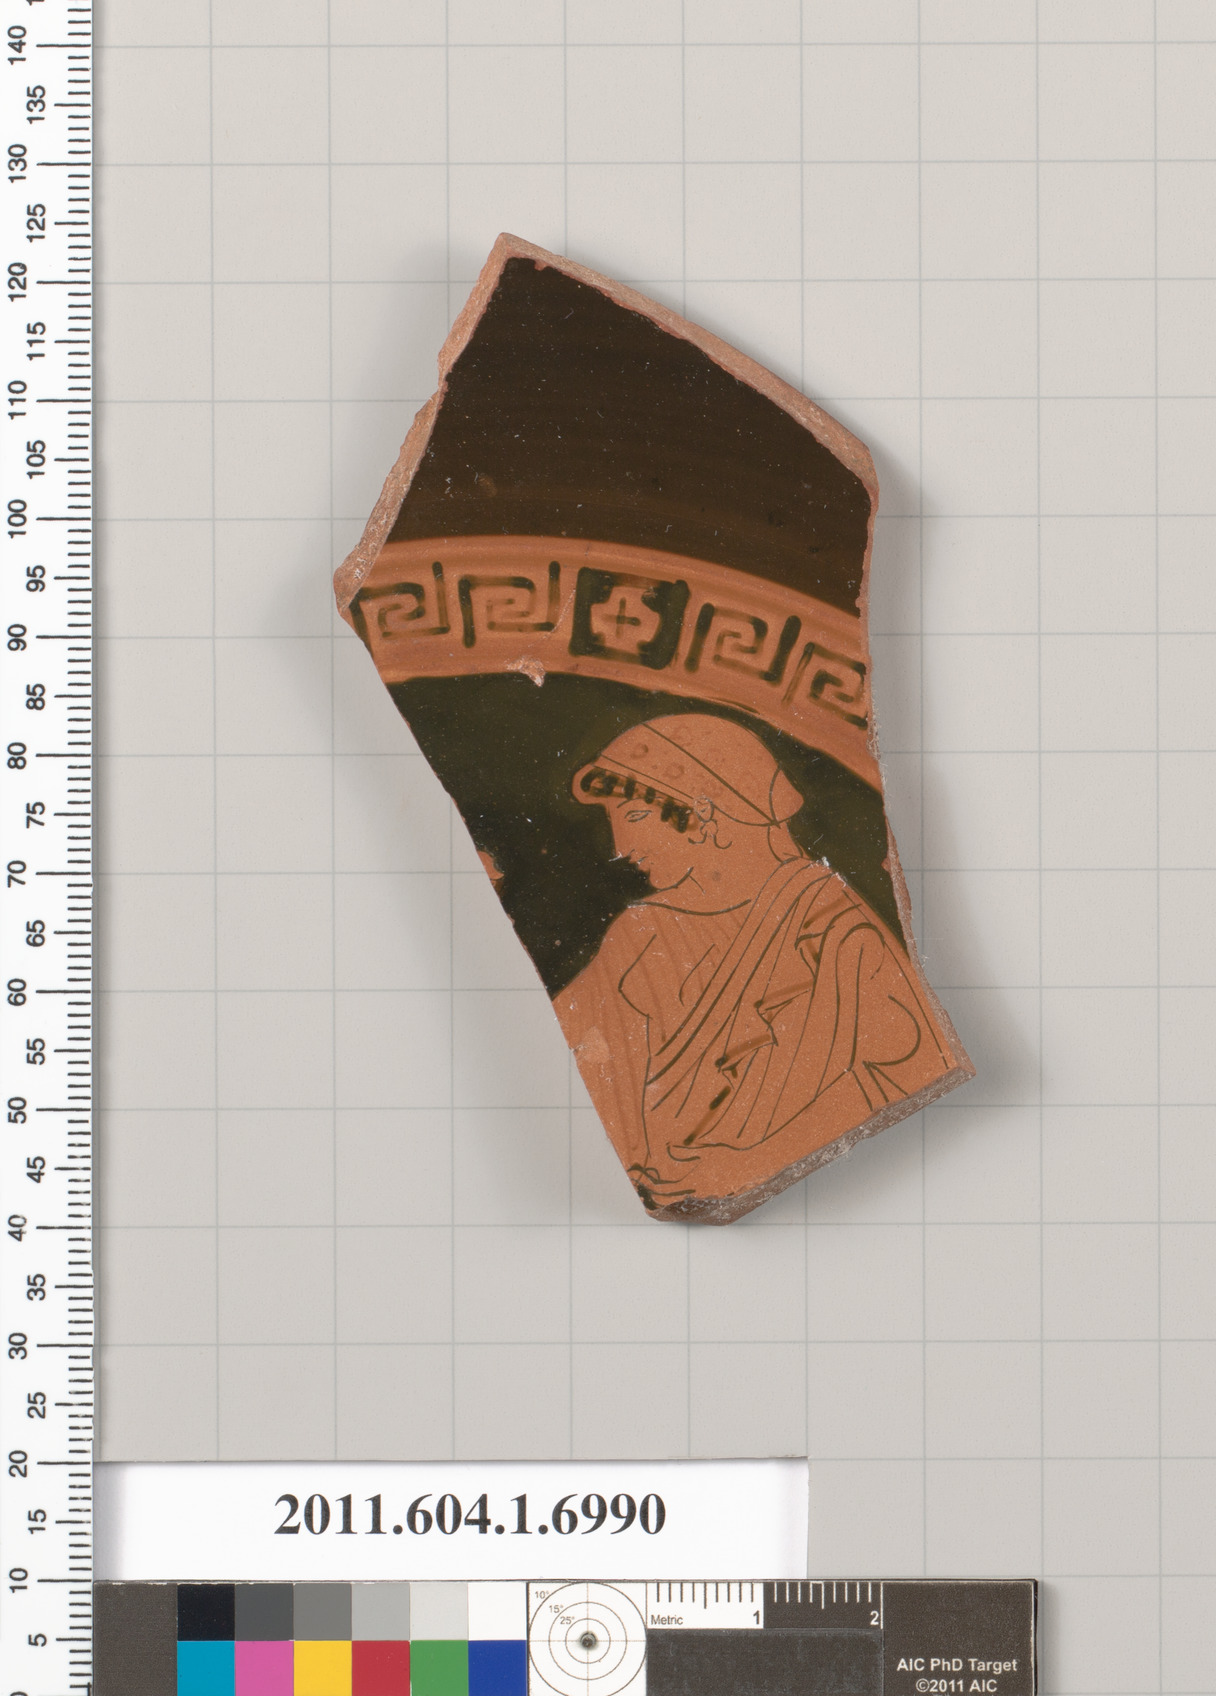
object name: kylix fragment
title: Terracotta fragment of a kylix (drinking cup)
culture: greek, attic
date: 500-480 BCE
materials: terracotta